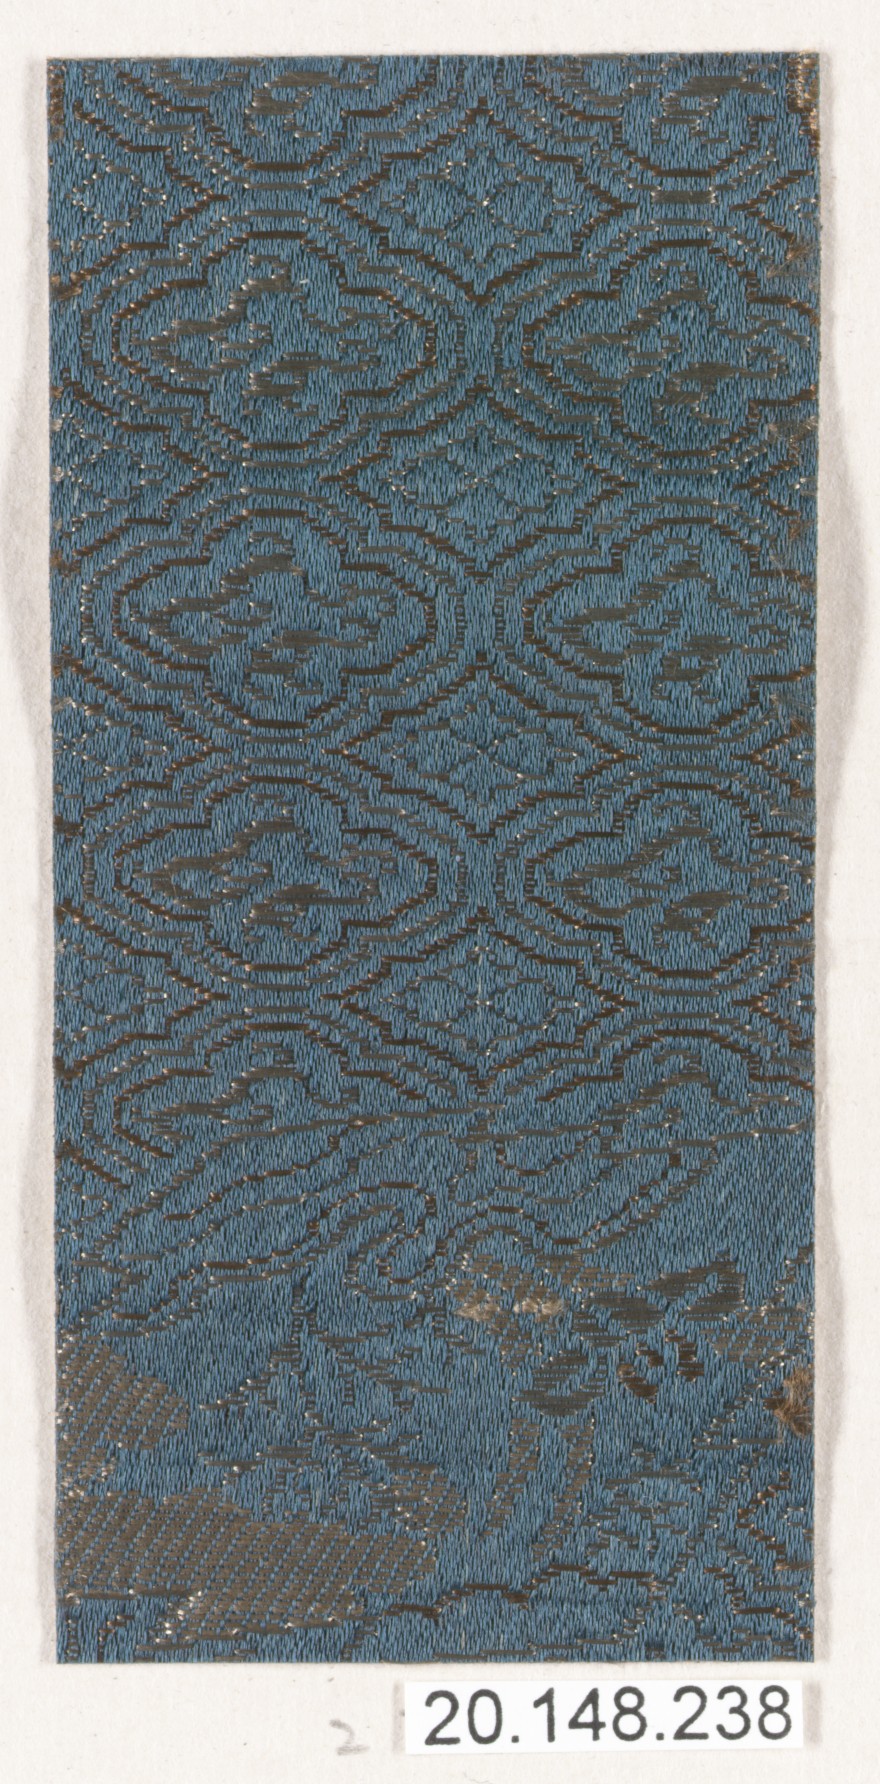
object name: piece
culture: japanese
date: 1701-1800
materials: silk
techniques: compound weave